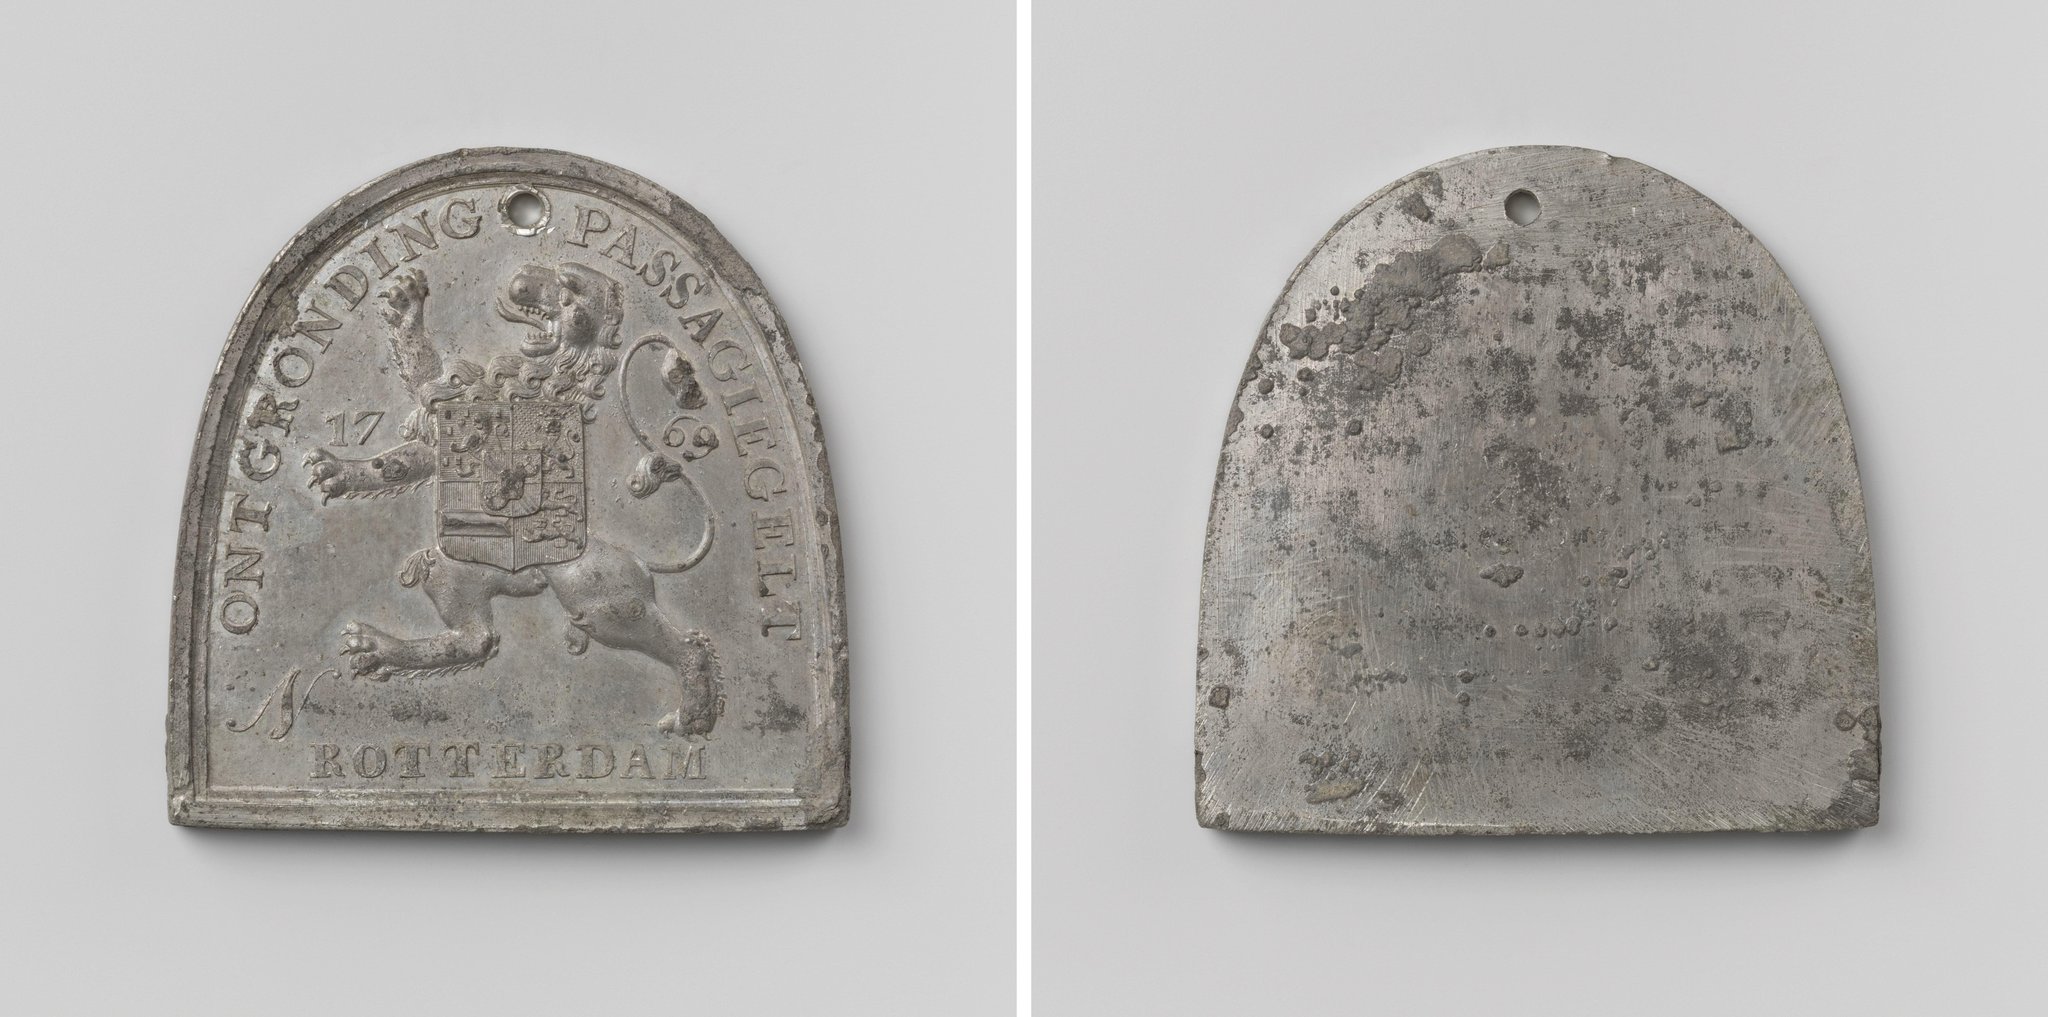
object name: ontgrondingspenning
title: Ontgronding te Rotterdam, penning bedoeld als bewijs voor turfdragers, -vullers of -tonners om turf in te mogen voeren uit de nieuw ontgronde venen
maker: Anonymous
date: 1769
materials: lead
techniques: casting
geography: rotterdam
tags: rotterdam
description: Eenzijdige loden penning met ronde boven- en rechthoekige onderzijde, en gat erin. Voorzijde: staande leeuw met wapenschild op borst tussen jaartal binnen omschrift. Keerzijde: blanco.